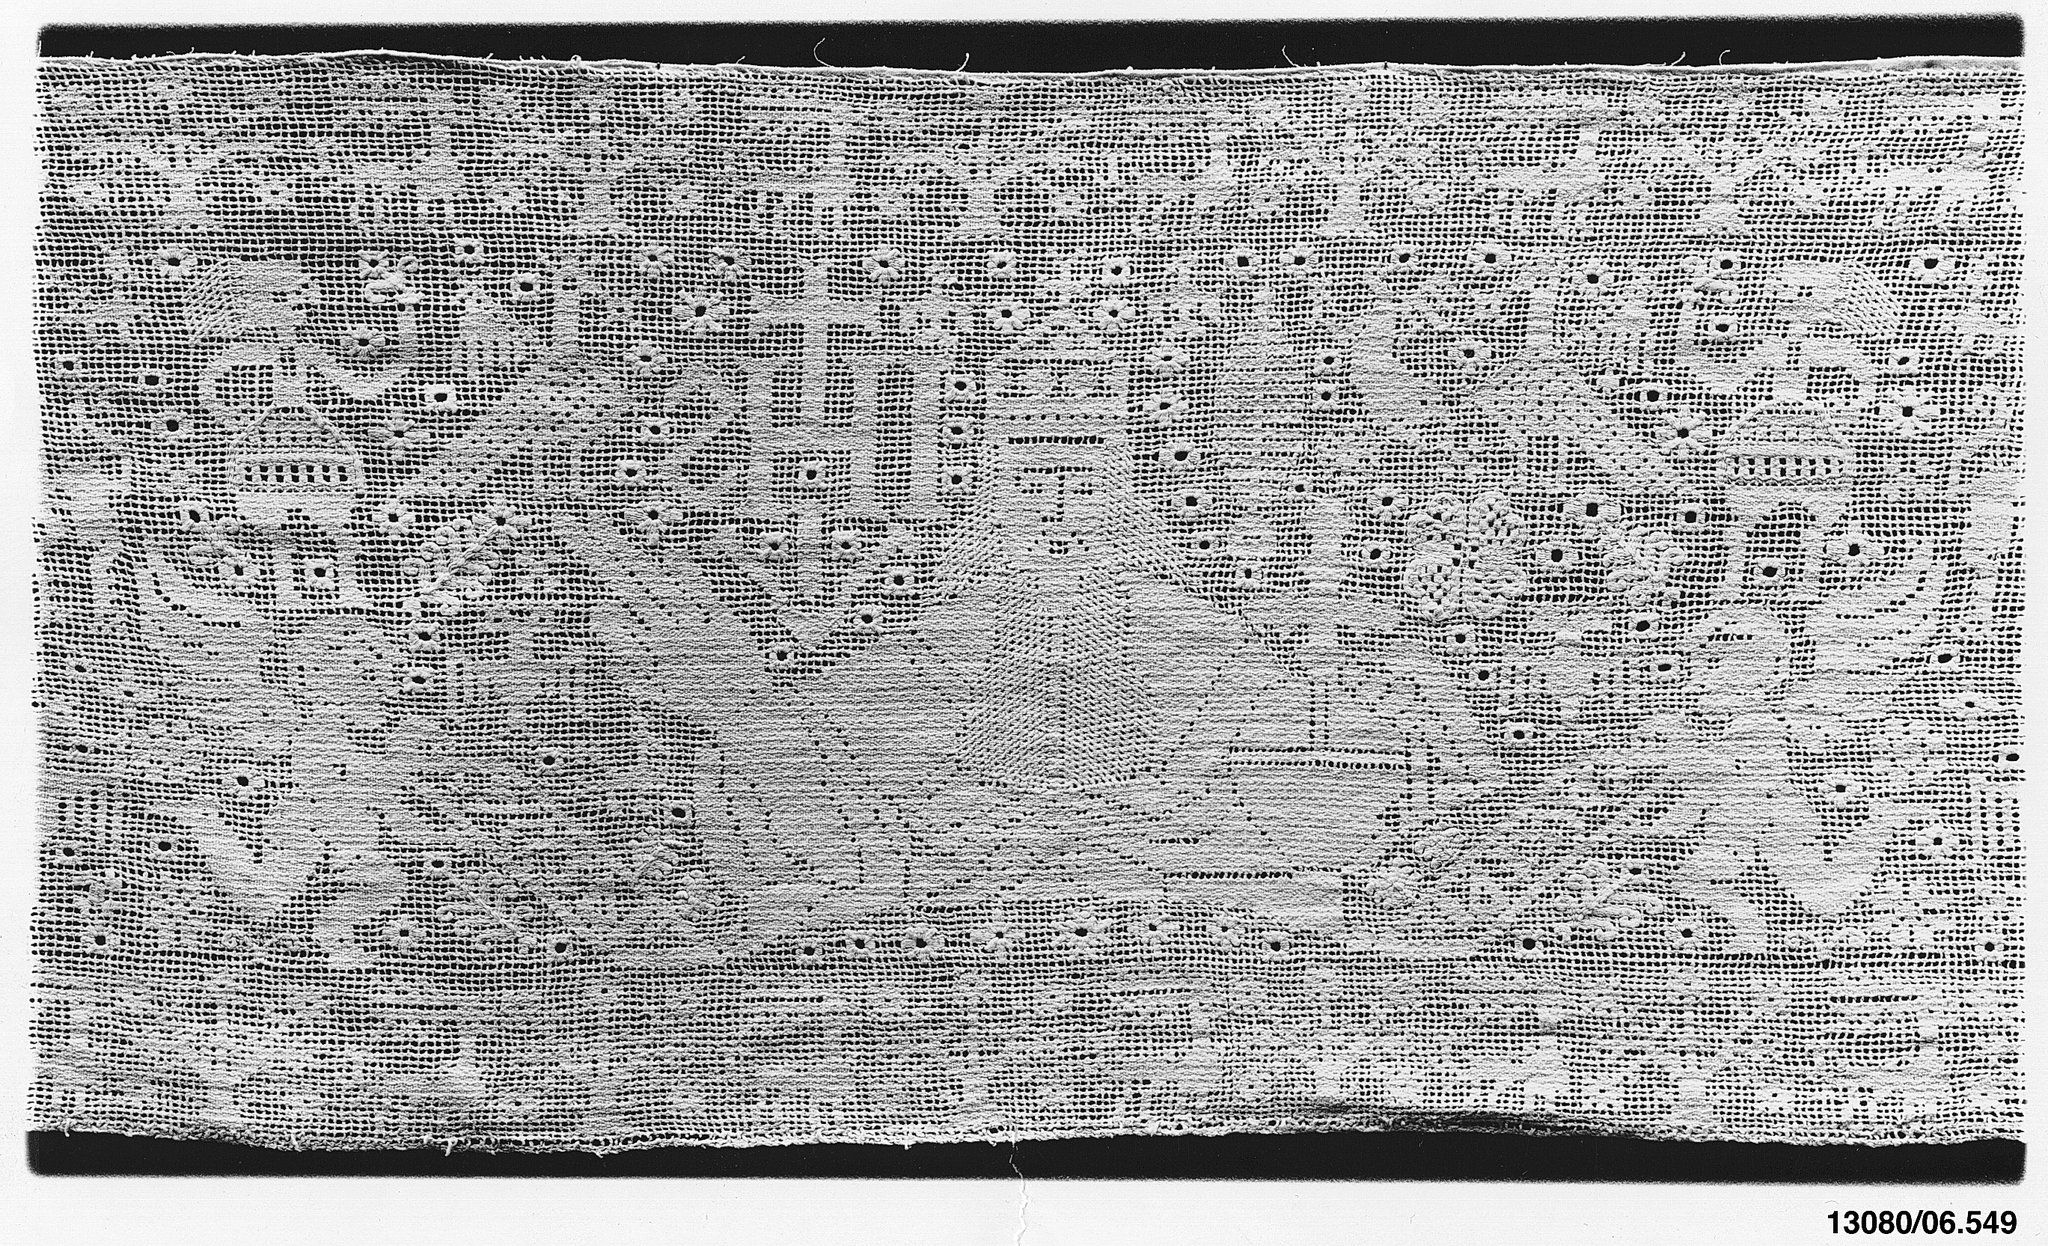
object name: altarpiece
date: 1501-1600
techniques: embroidery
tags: putti,christ